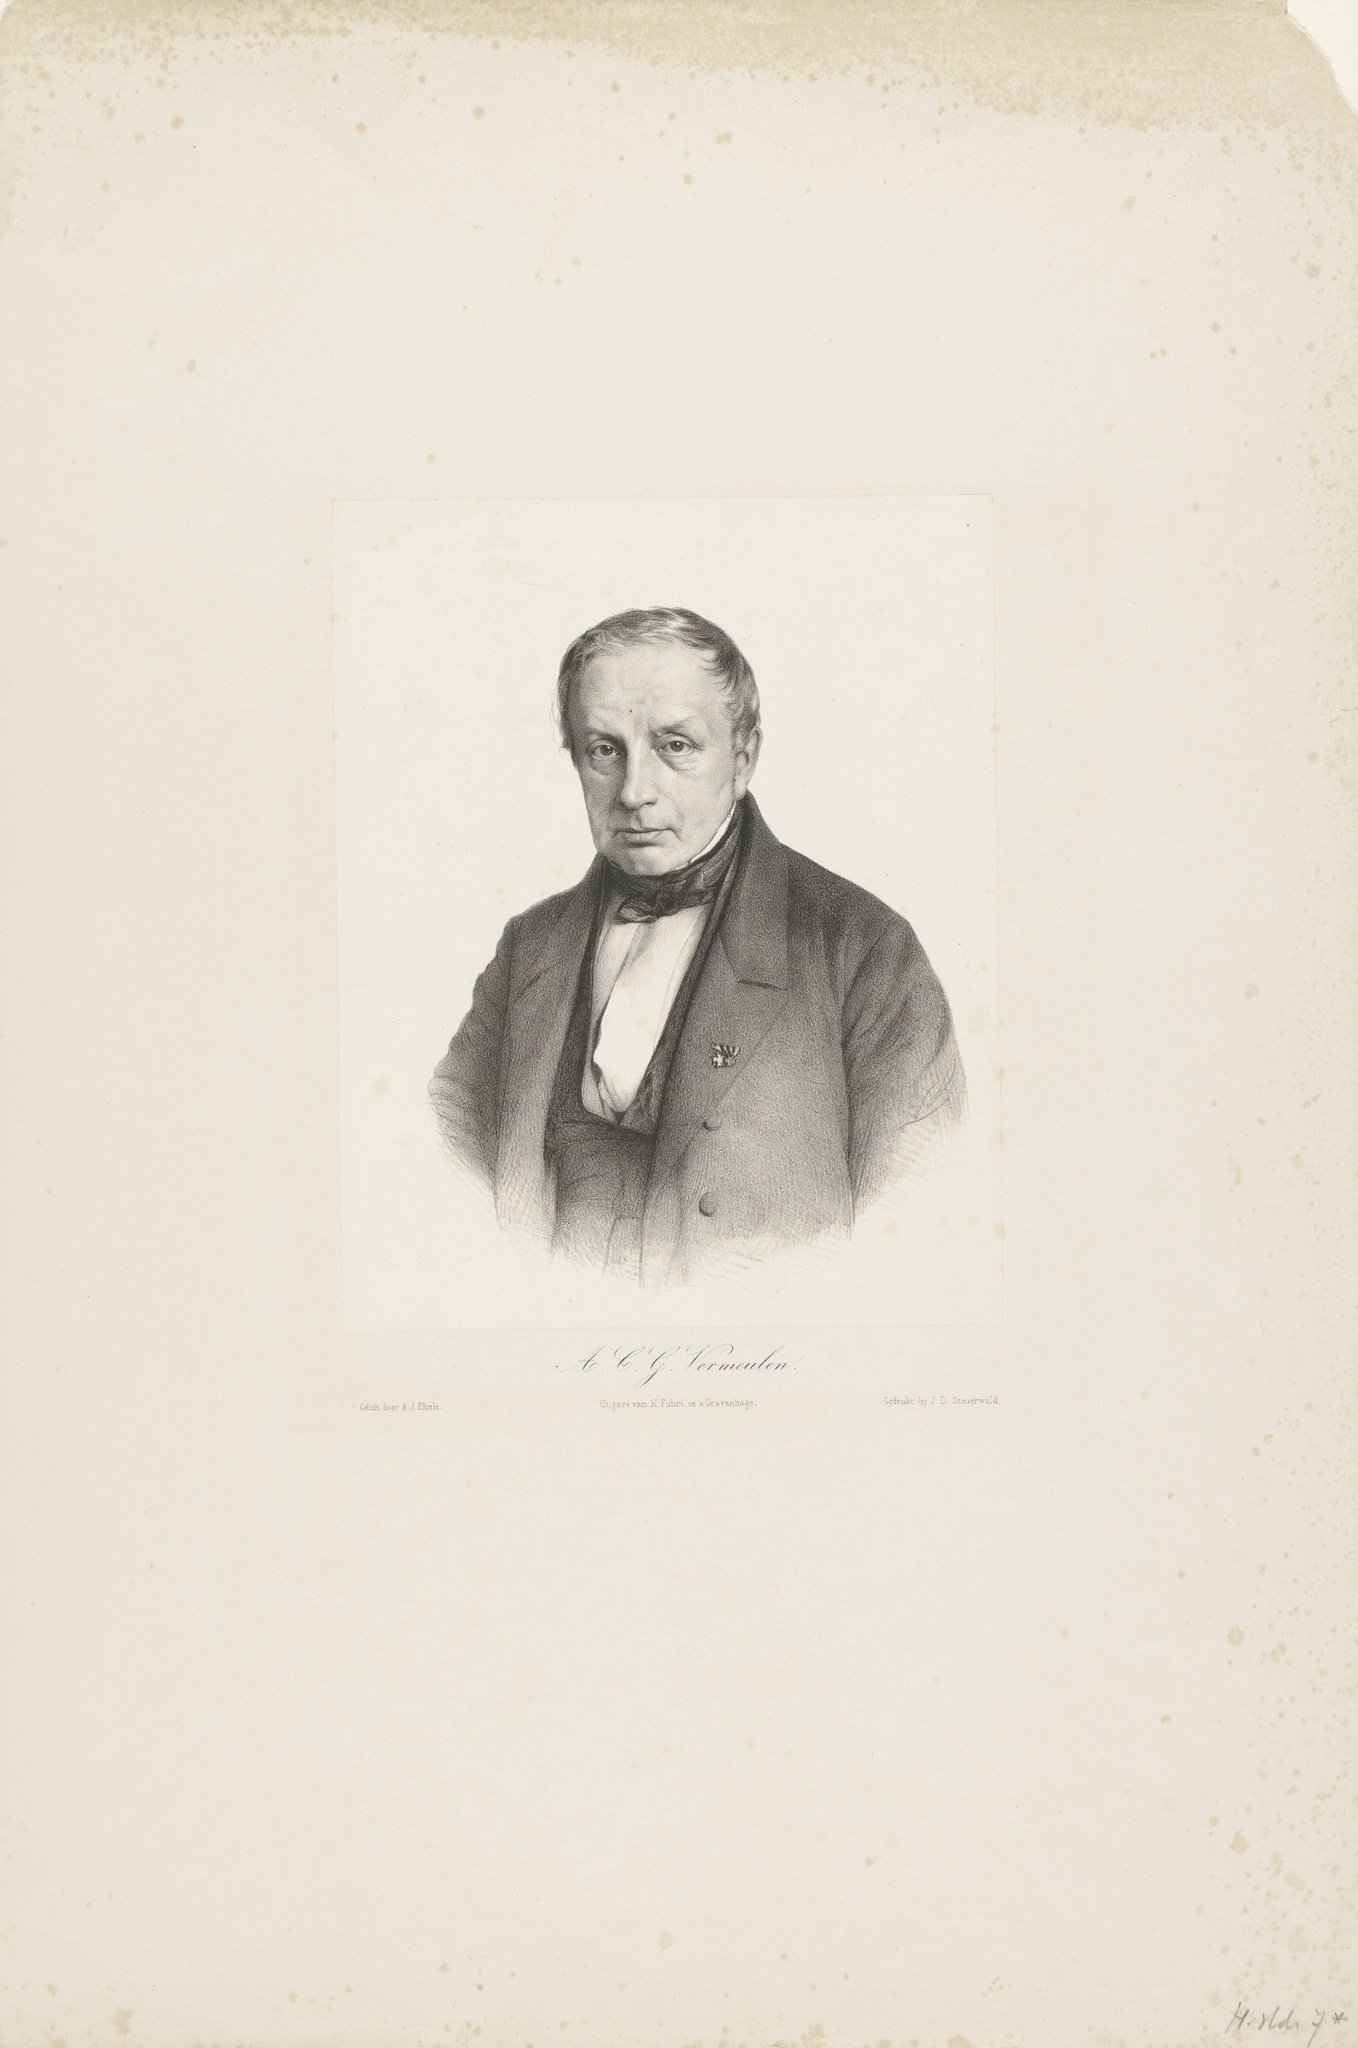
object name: print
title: Portret van Adrianus Catharinus Gerardus Vermeulen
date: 1837-1855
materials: paper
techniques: lithograph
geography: the hague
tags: knighthood order, historical persons (+ (full) bust portrait)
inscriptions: collector's mark: Lugt 2228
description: De geportretteerde draagt twee ridderorden op de revers van zijn jas. Onder het portret zijn naam. Onderdeel van een serie van twaalf portretten naar daguerrotypieën en twaalf stadsgezichten. Ter gelegenheid van het Muziekfeest ter viering van het 25-jarige bestaan van de Maatschappij ter Bevordering van Toonkunst in Rotterdam, 12-15 juli 1854.